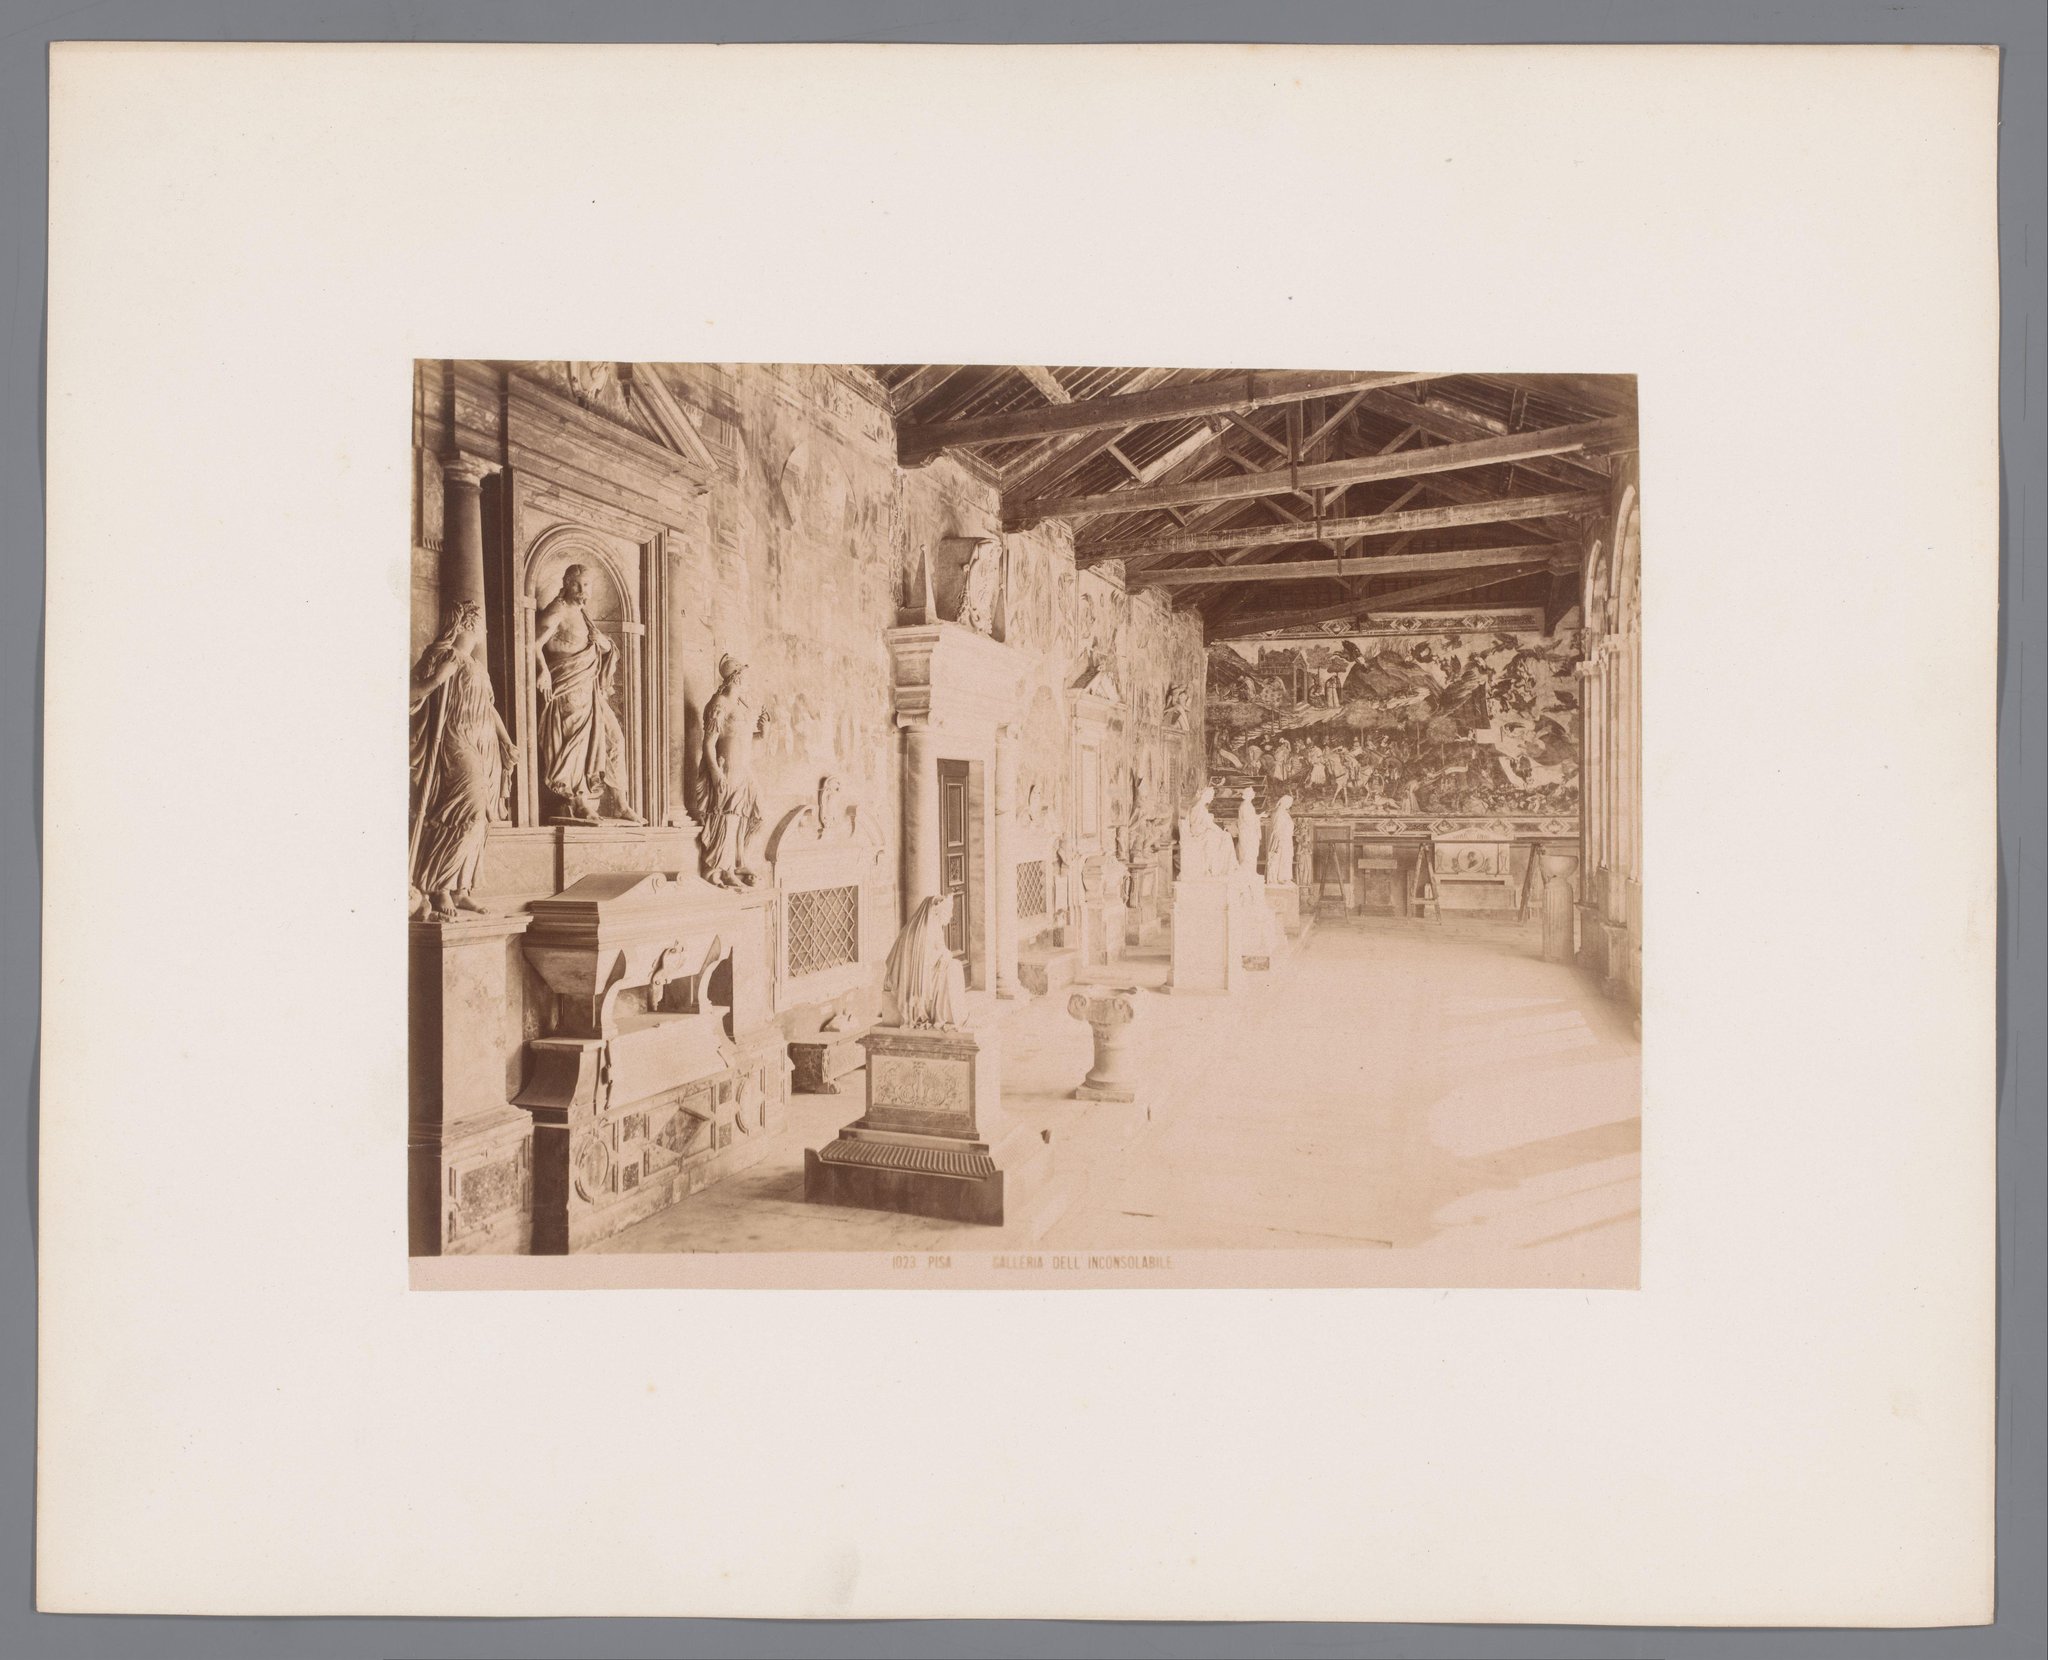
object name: photograph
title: Beeldengalerij in het Camposanto te Pisa, Italië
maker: Anonymous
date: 1851-1900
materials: cardboard, paper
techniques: albumen print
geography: pisa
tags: gallery of sculptures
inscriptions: number: ‘1023’